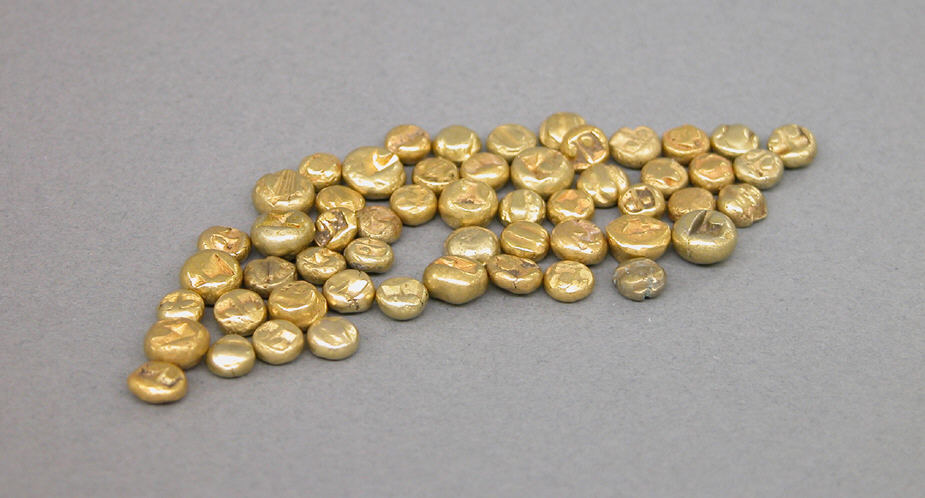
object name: coin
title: Fifty-Four Small Piloncito Coins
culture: indonesian, javanese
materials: gold